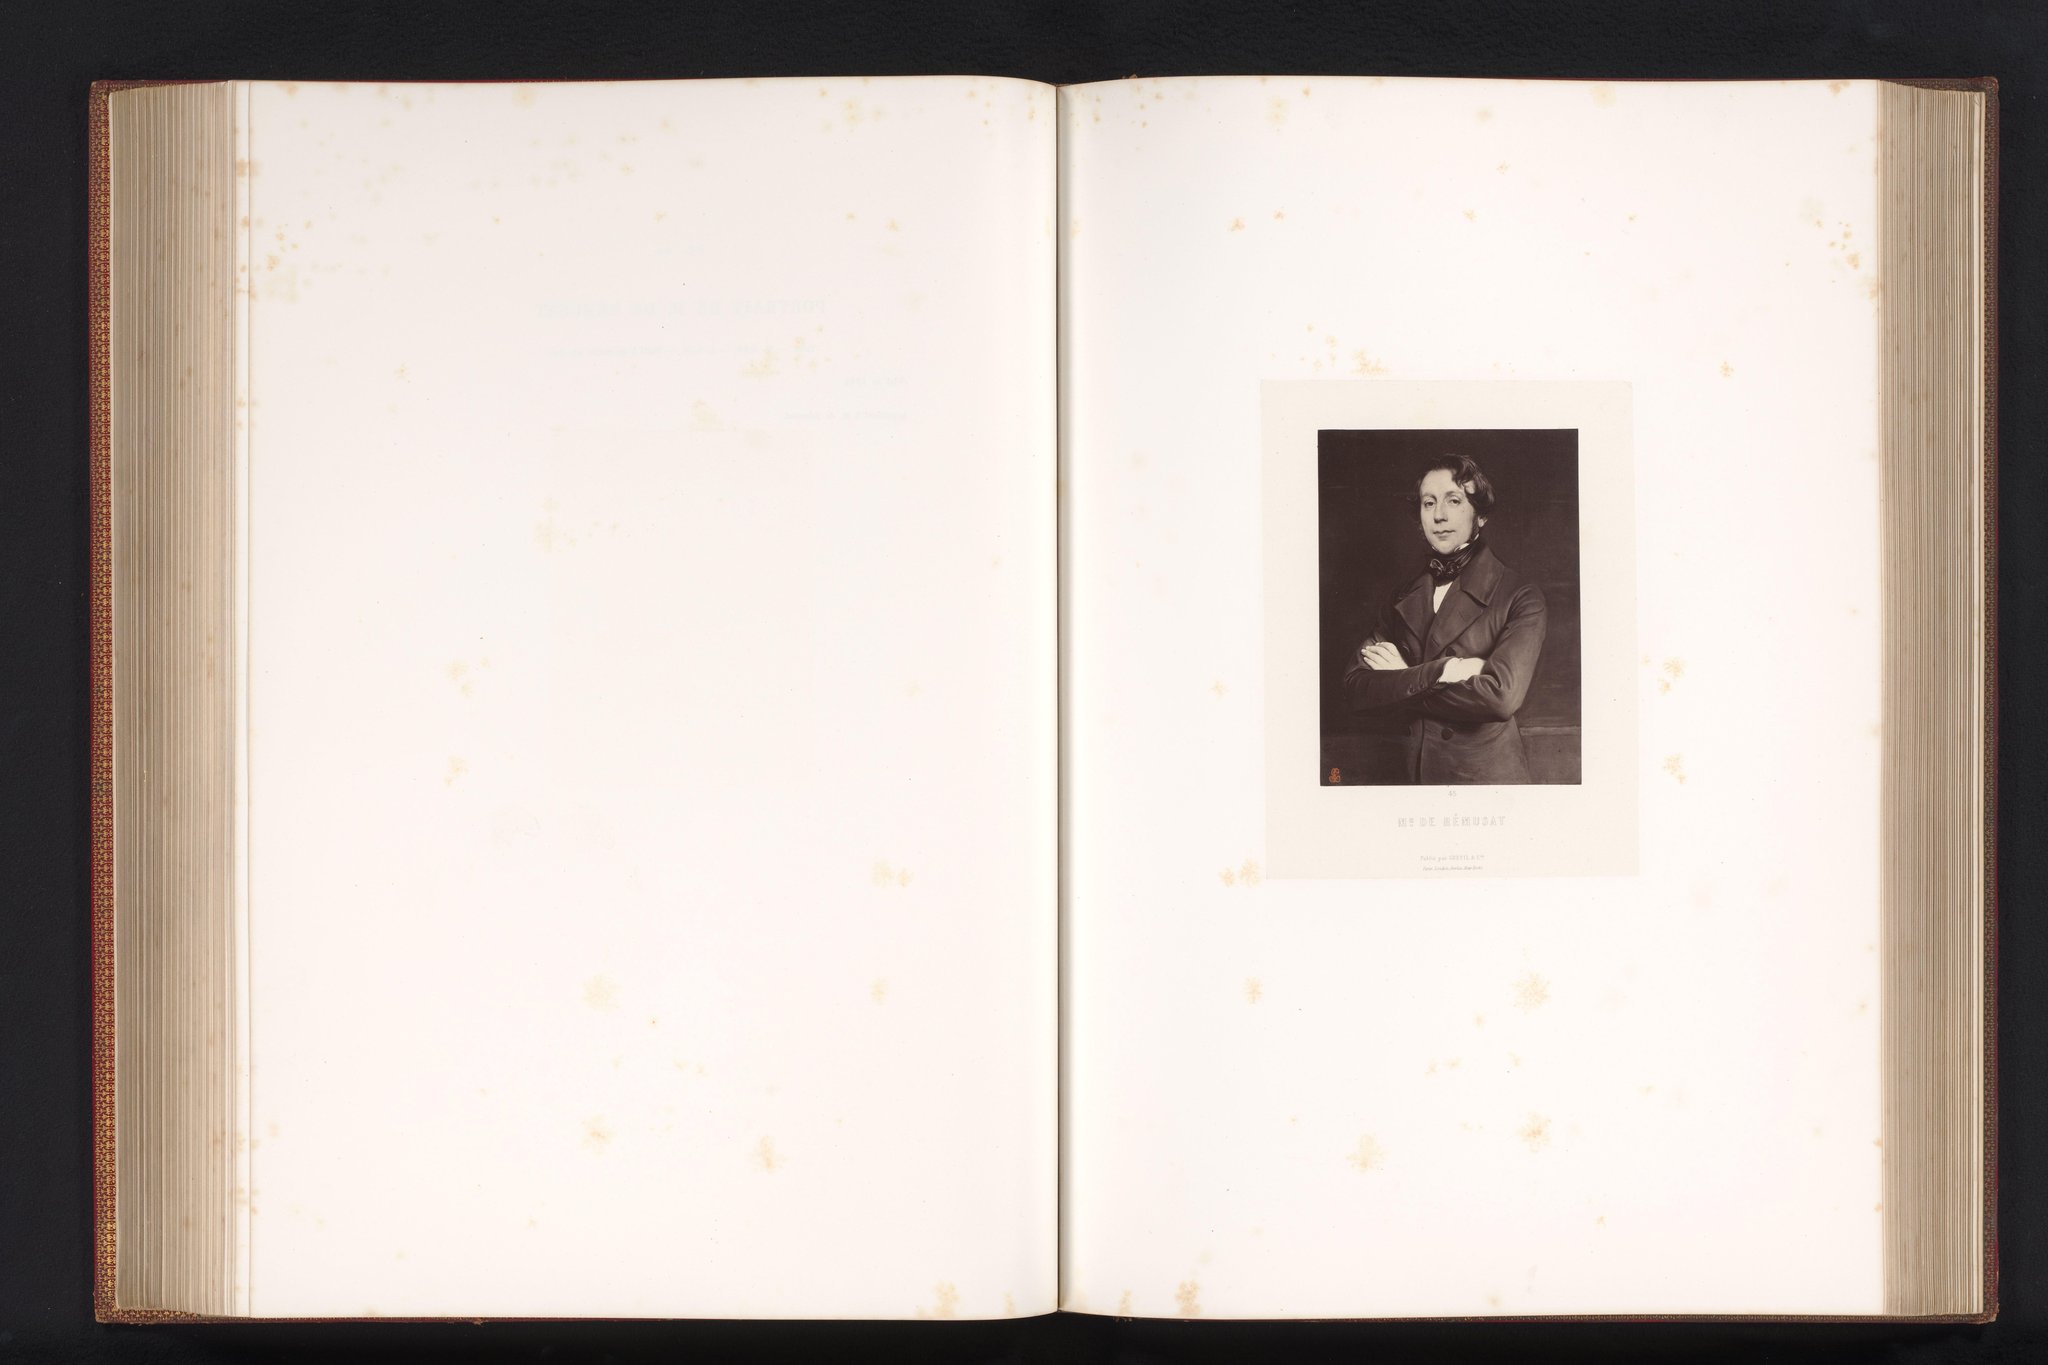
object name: reproduction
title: Fotoreproductie van een geschilderd portret van Charles de Rémusat door Paul Delaroche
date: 1853-1858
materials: paper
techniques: albumen print, engraving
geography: paris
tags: historical persons, portrait of a writer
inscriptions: initials: ‘GC’